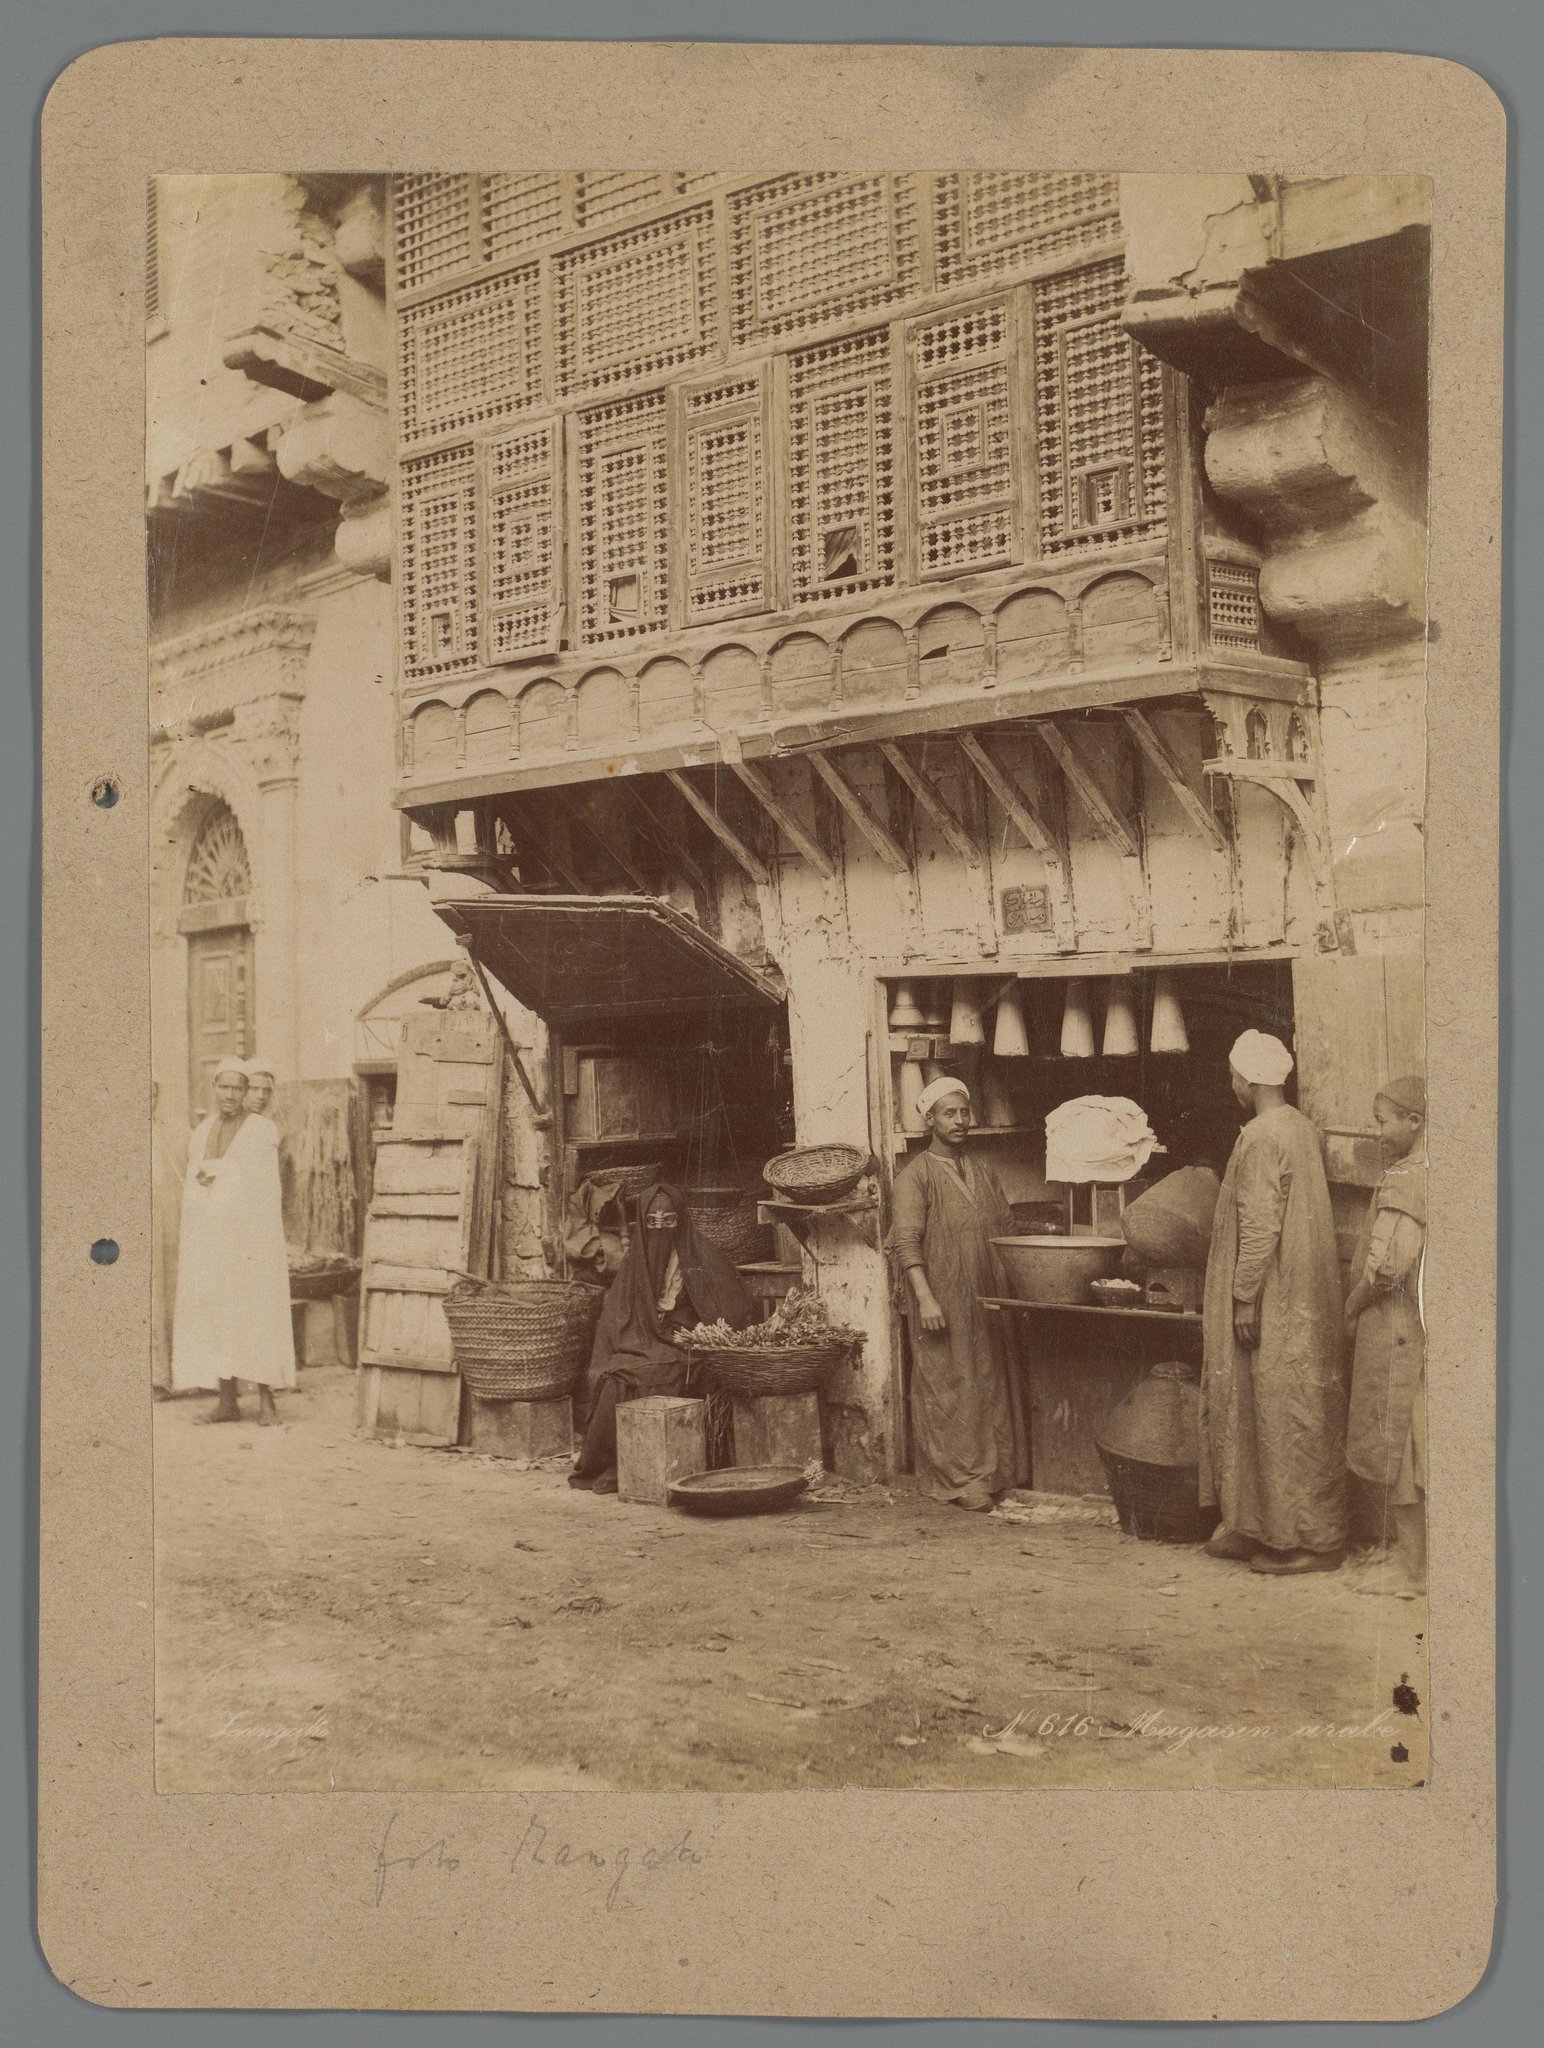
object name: photograph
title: Gezicht op een winkel met mashrabiyavensters in de Arabische wijk in Caïro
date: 1870-1910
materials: cardboard, paper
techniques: albumen print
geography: cairo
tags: shop, store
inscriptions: number: ‘No 616’